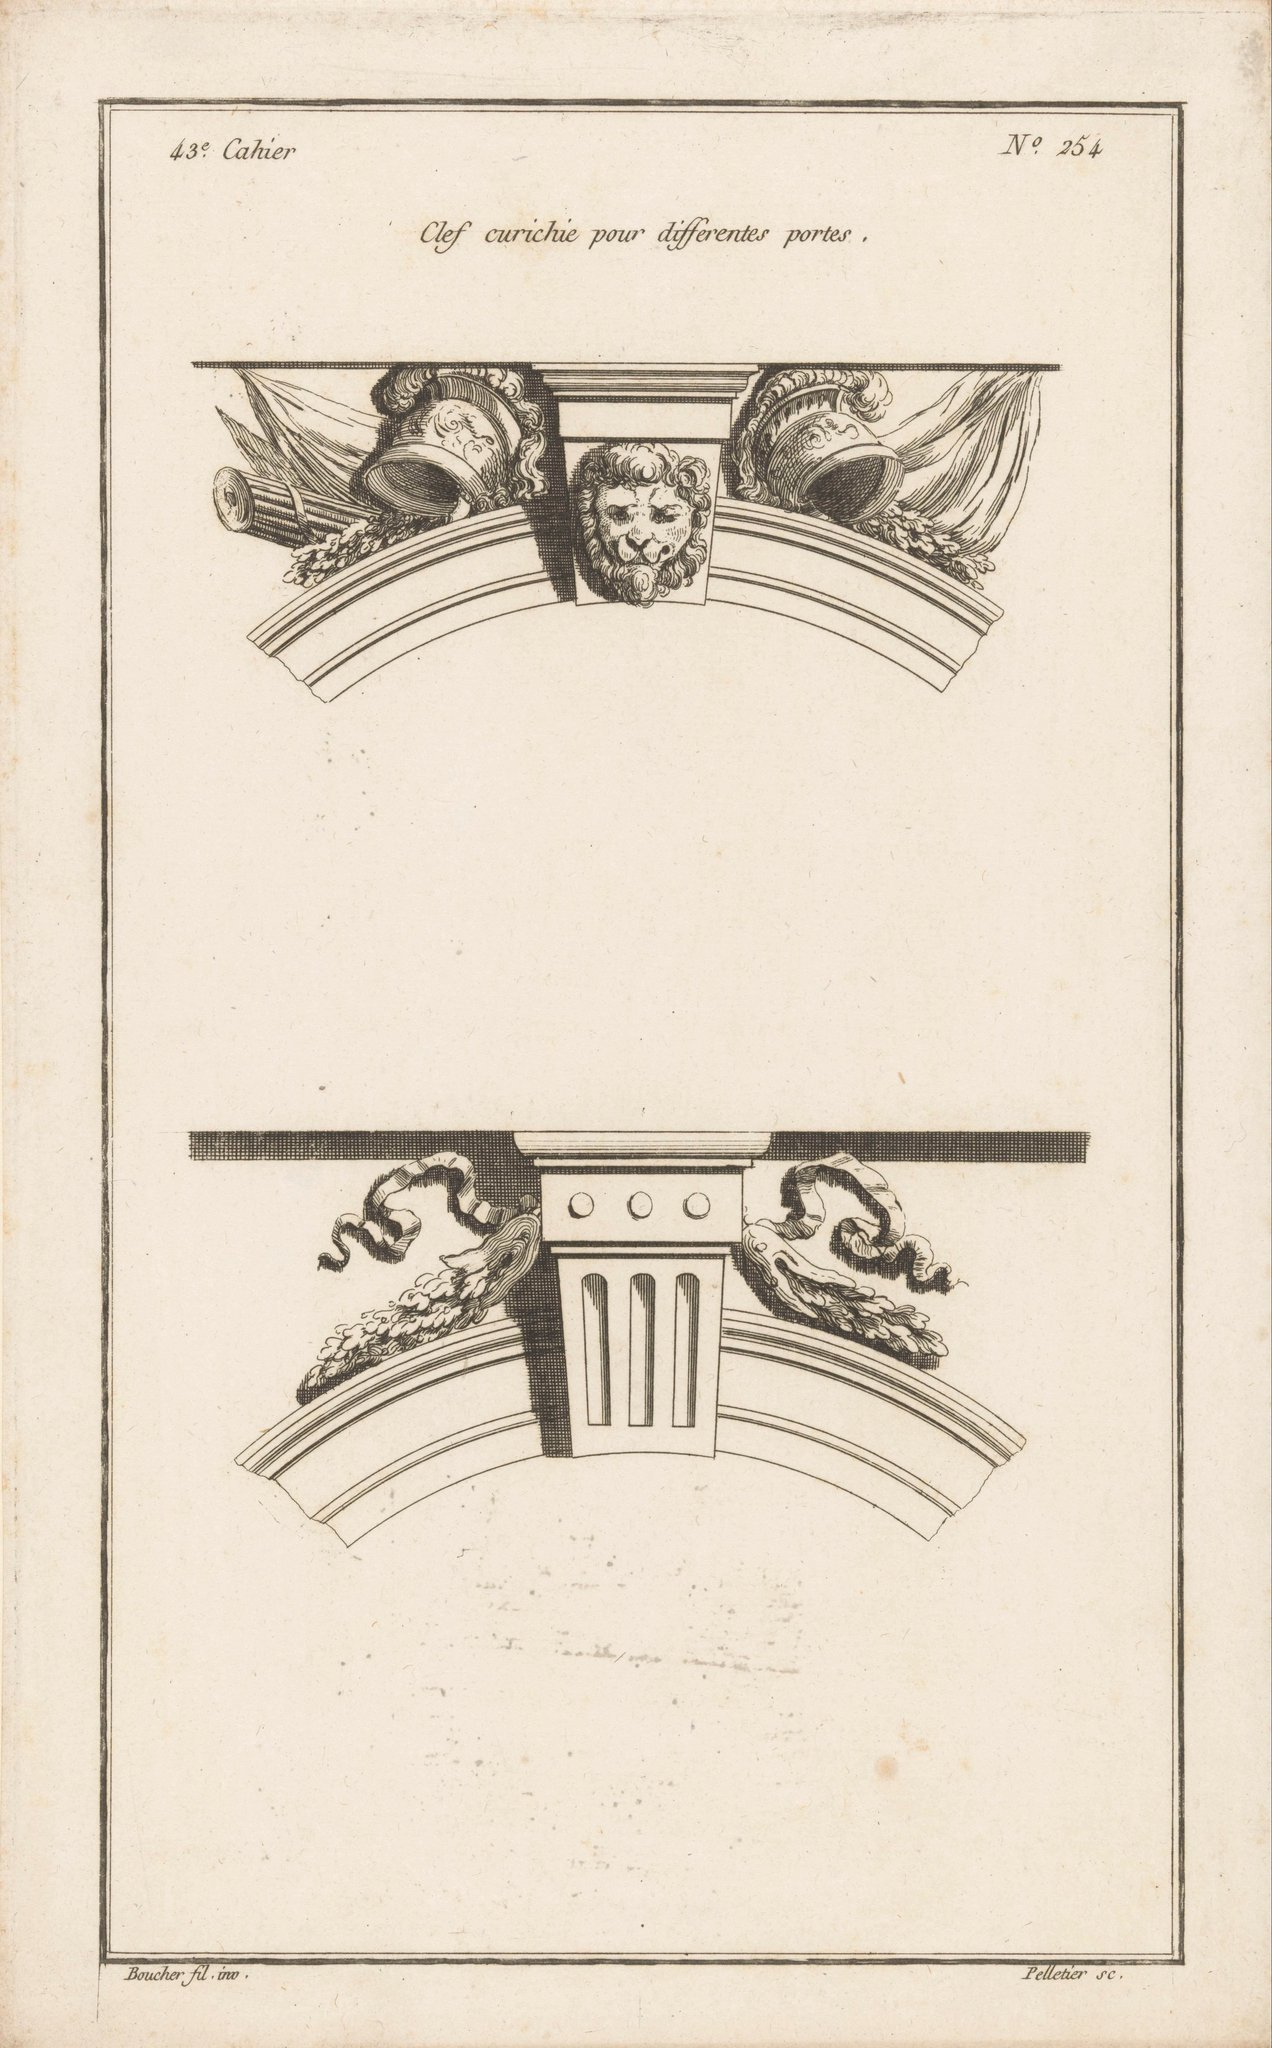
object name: ornament print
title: Clef curichie pour differentes portes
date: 1772-1779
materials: paper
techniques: engraving, etching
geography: paris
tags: helmet, lion's head ~ ornament, foliage ~ ornament, keystone ~ architecture, weapons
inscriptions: collector's mark: Lugt 2228, collector's mark: Lugt 2760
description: Twee sluitstenen met een leeuwenkop, helmen en wapens en onder met bladmotieven en linten. Prentnummer 254.